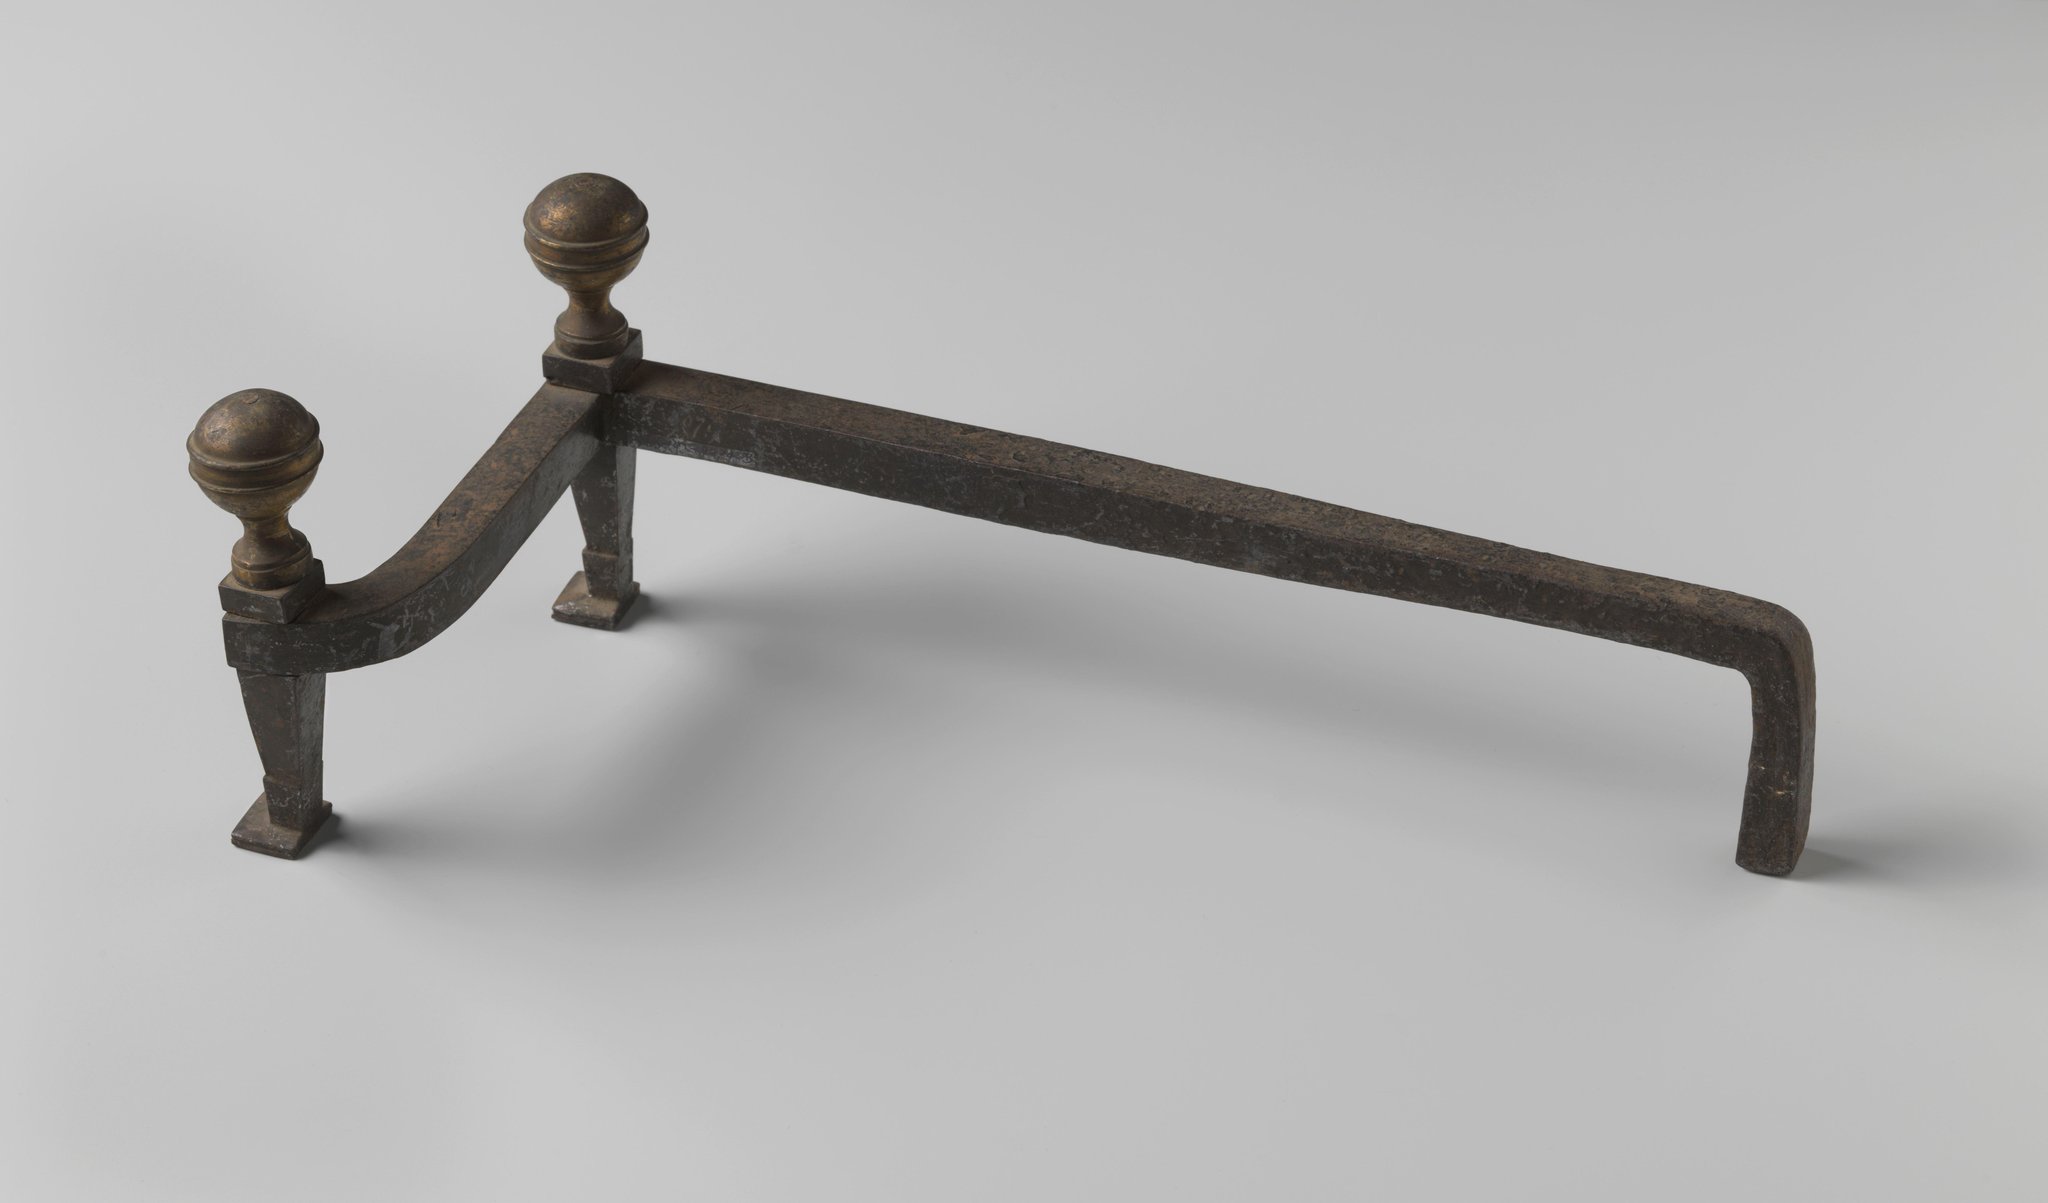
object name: vuurijzer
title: Vuurijzer met koperen knoppen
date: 1400-1950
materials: copper, iron